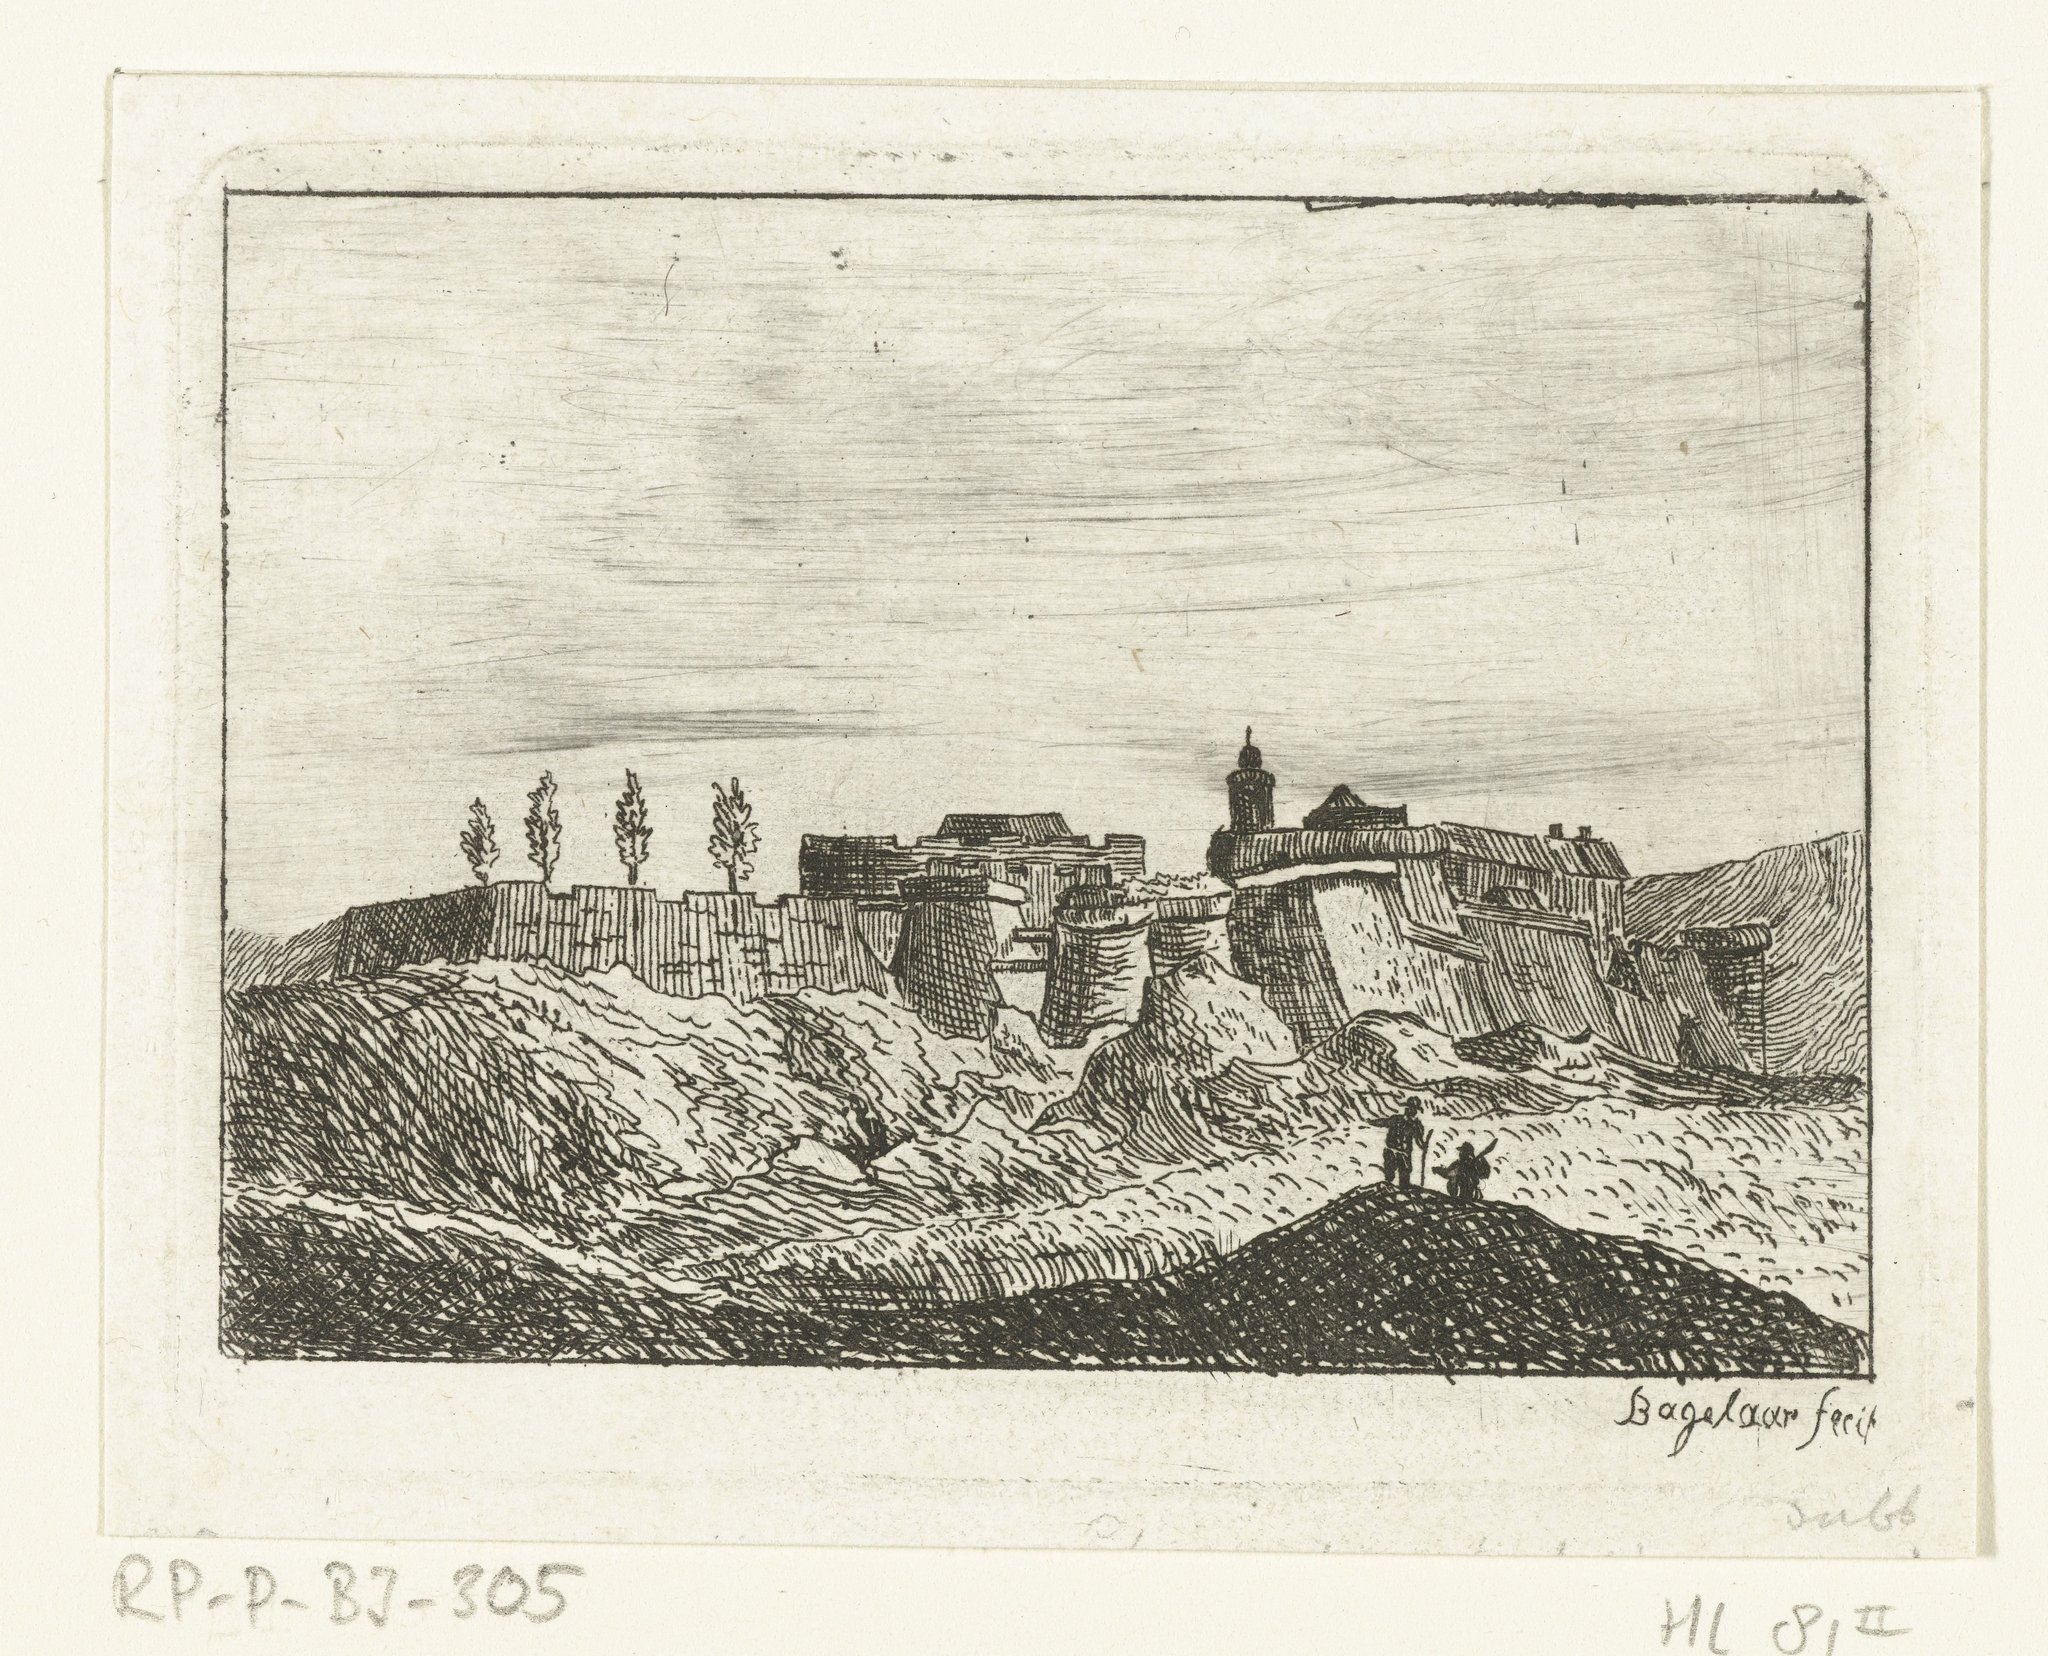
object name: print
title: Gezicht op Fort Ehrenbreitstein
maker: ernst willem jan bagelaar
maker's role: draughtsman, print maker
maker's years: 1775-1837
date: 1798-1837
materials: paper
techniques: drypoint, etching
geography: netherlands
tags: ruin of a dwelling, house, castle, etc.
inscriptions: collector's mark: Lugt 2228